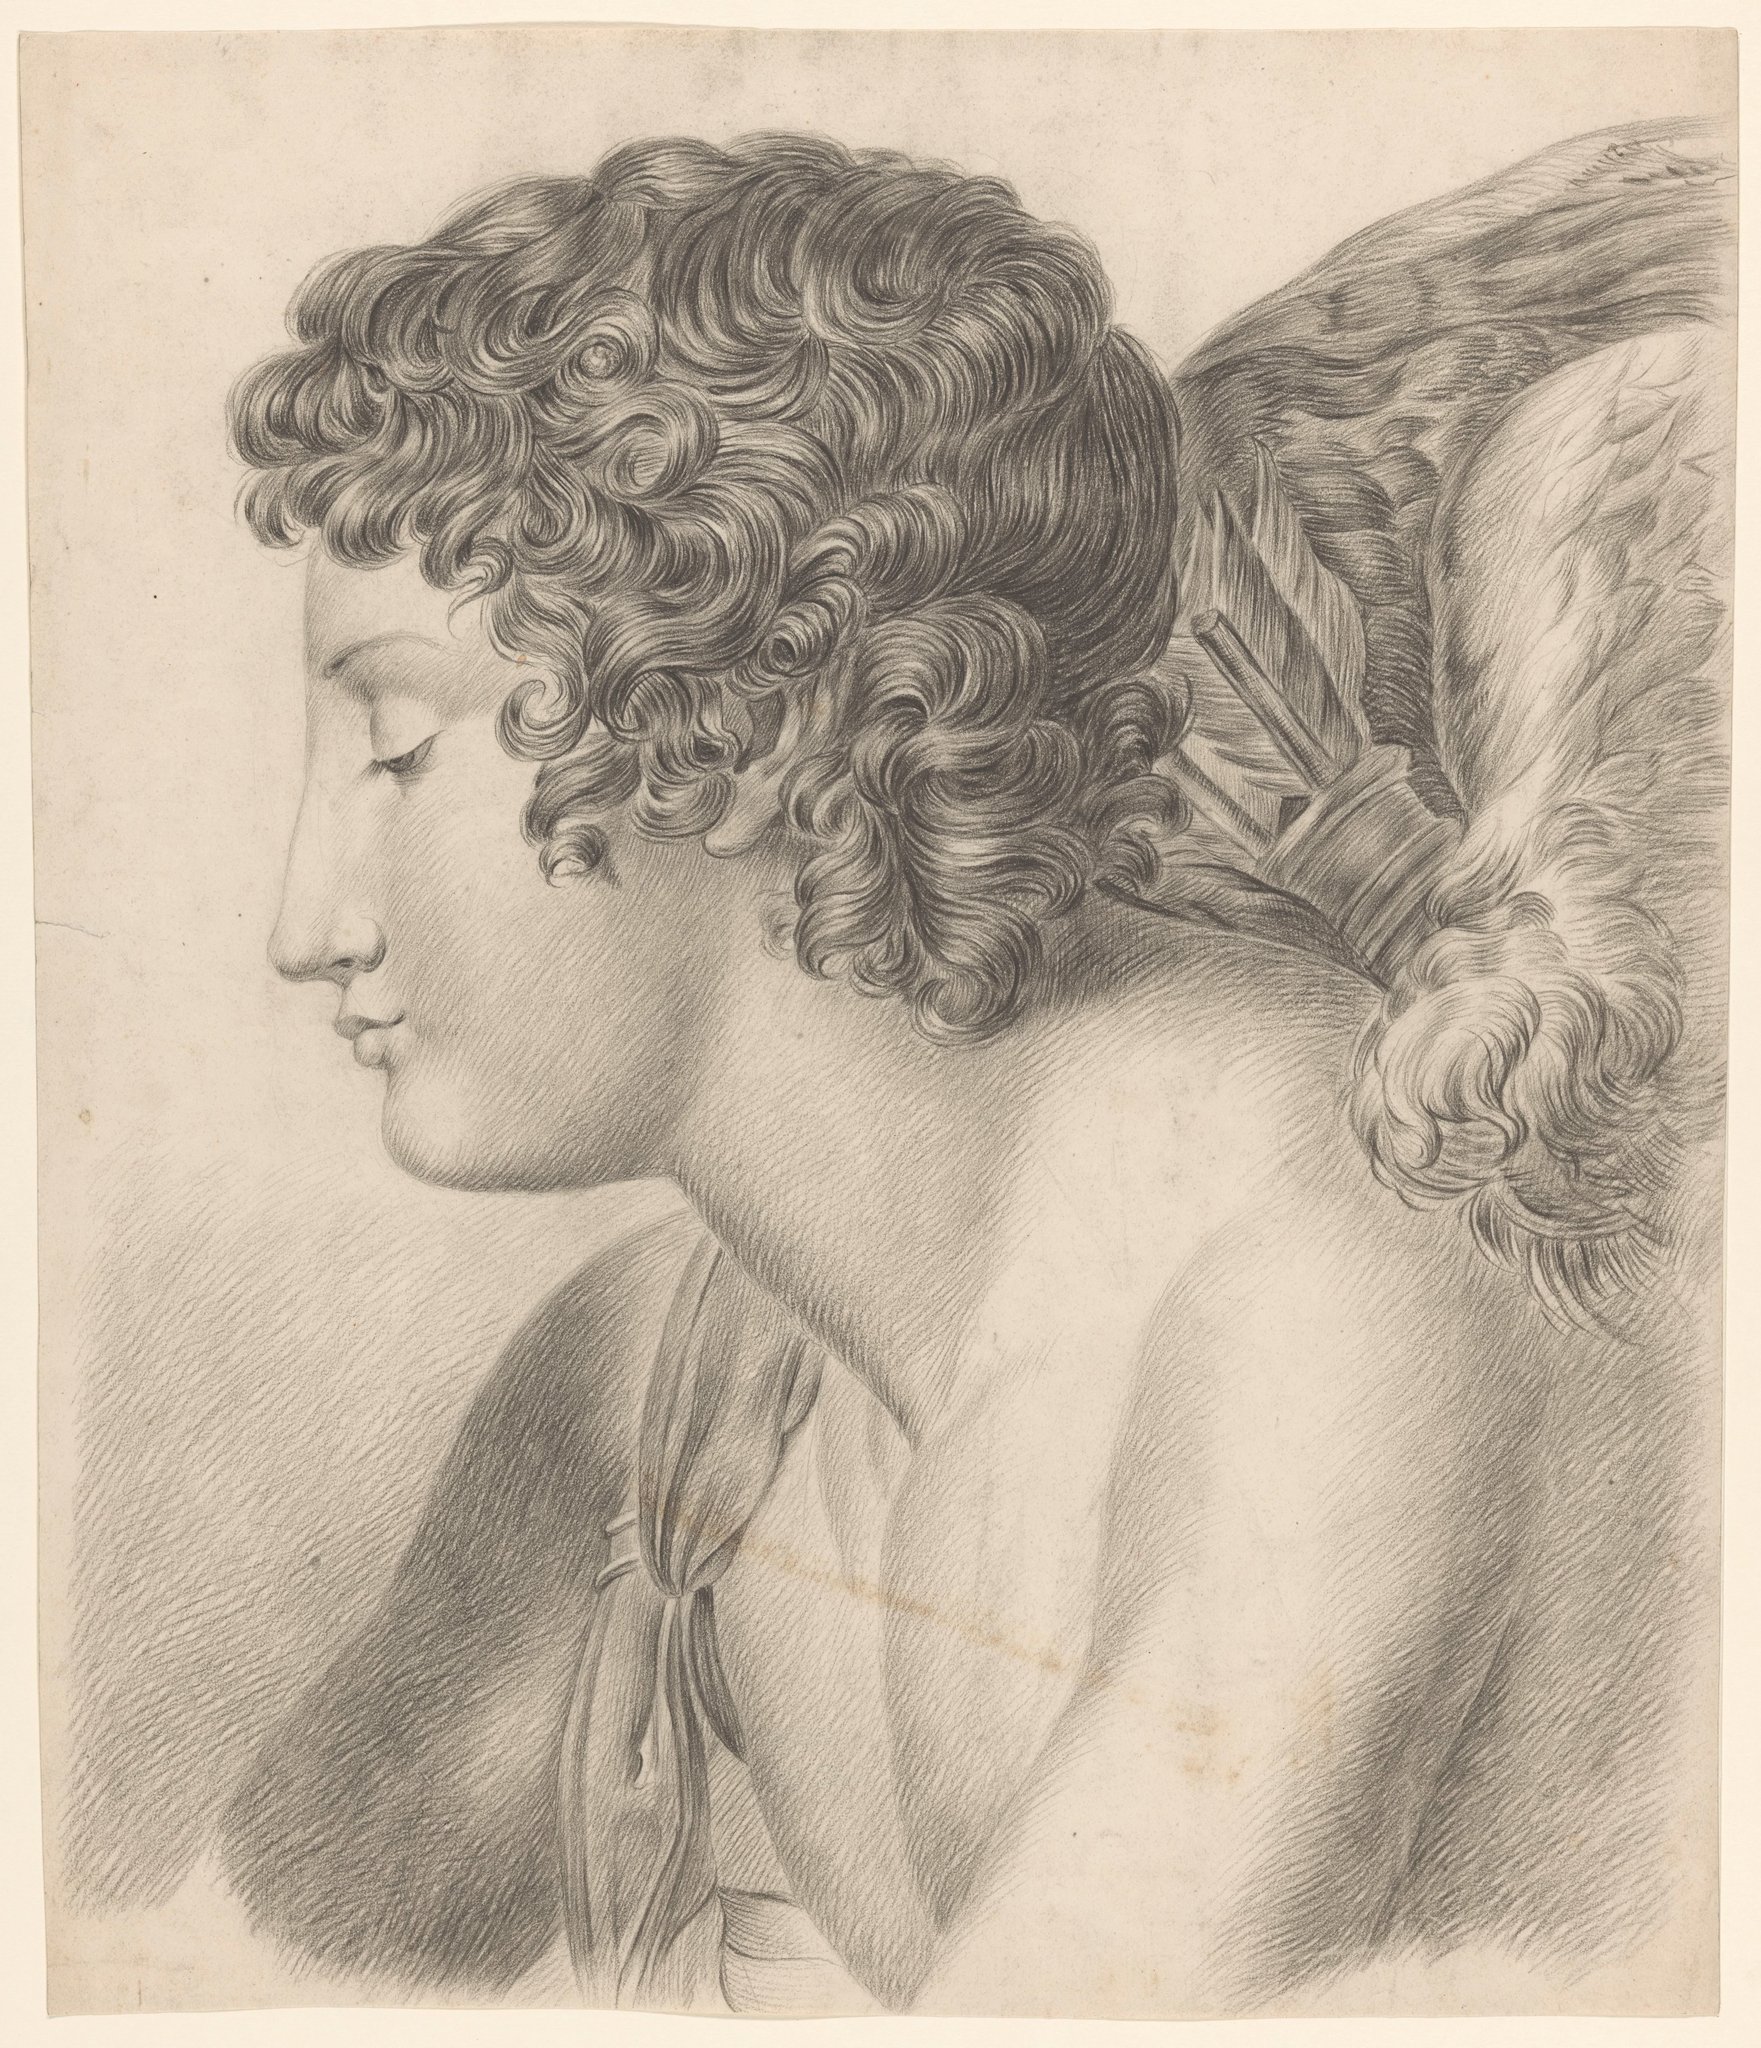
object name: figuurstudie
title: Studie van een engel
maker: johannes tavenraat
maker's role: draughtsman, painter, print maker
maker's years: 1809-1881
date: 1819-1881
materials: chalk, paper